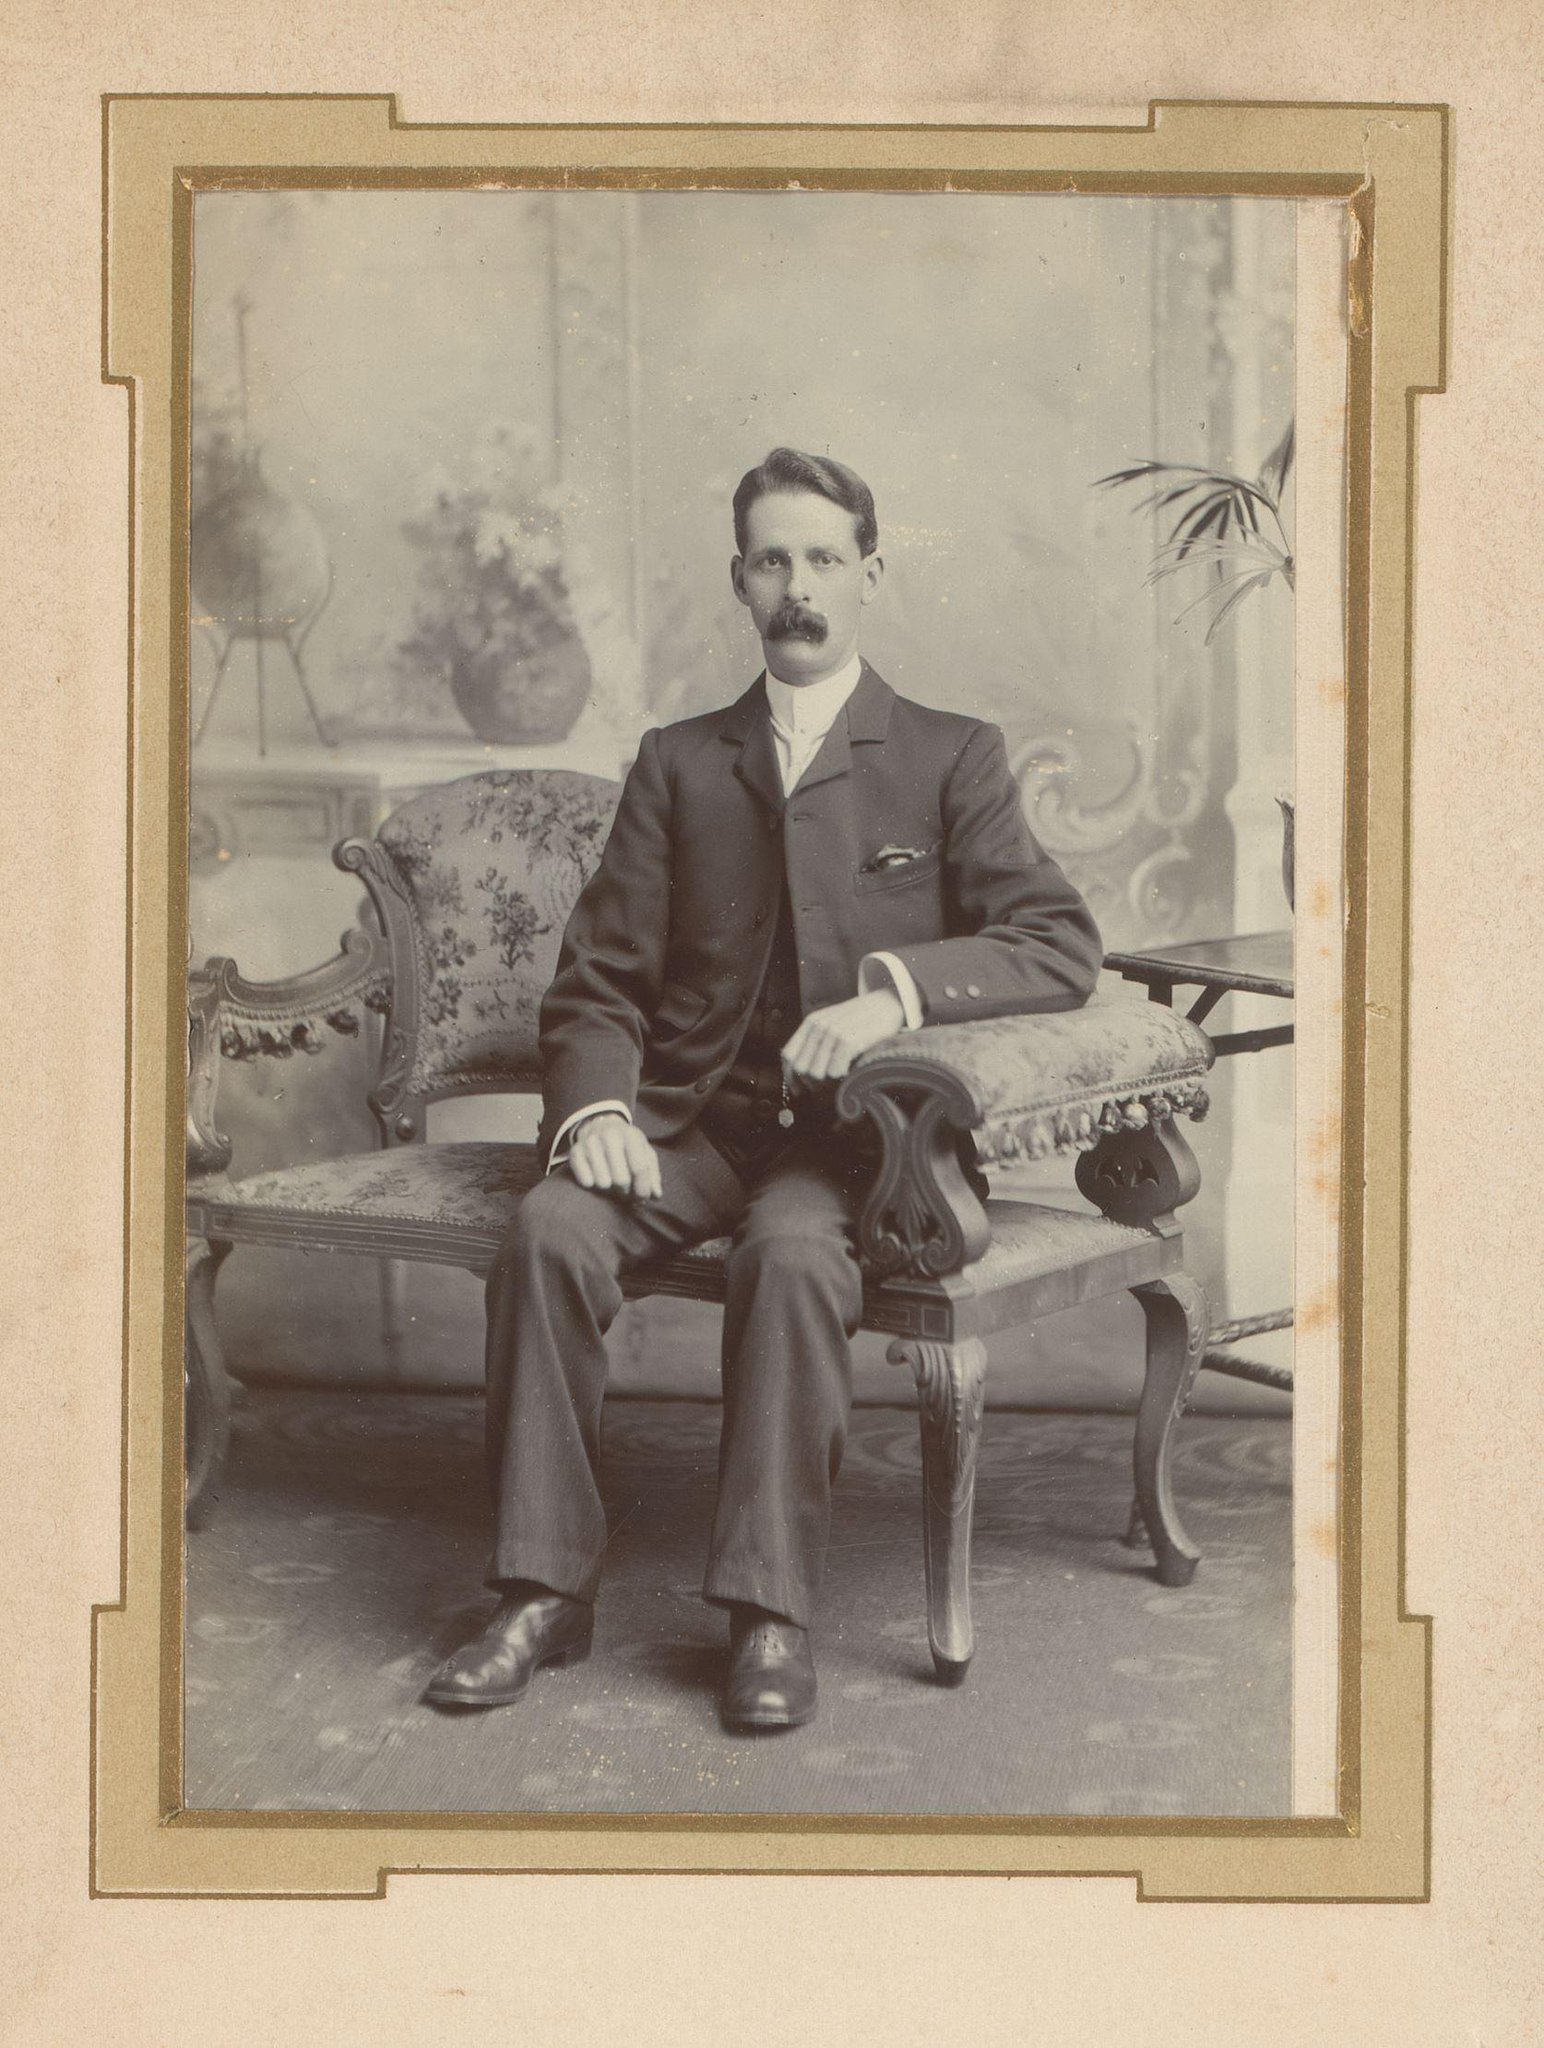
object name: cabinet photograph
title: Portret van een man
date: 1860-1900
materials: cardboard, photographic support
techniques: gelatin silver print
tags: sitting figure, adult man, historical persons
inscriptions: number: ‘62817’, inscription: ‘A. & G. Taylor/ Sunderland/ & South Fields’